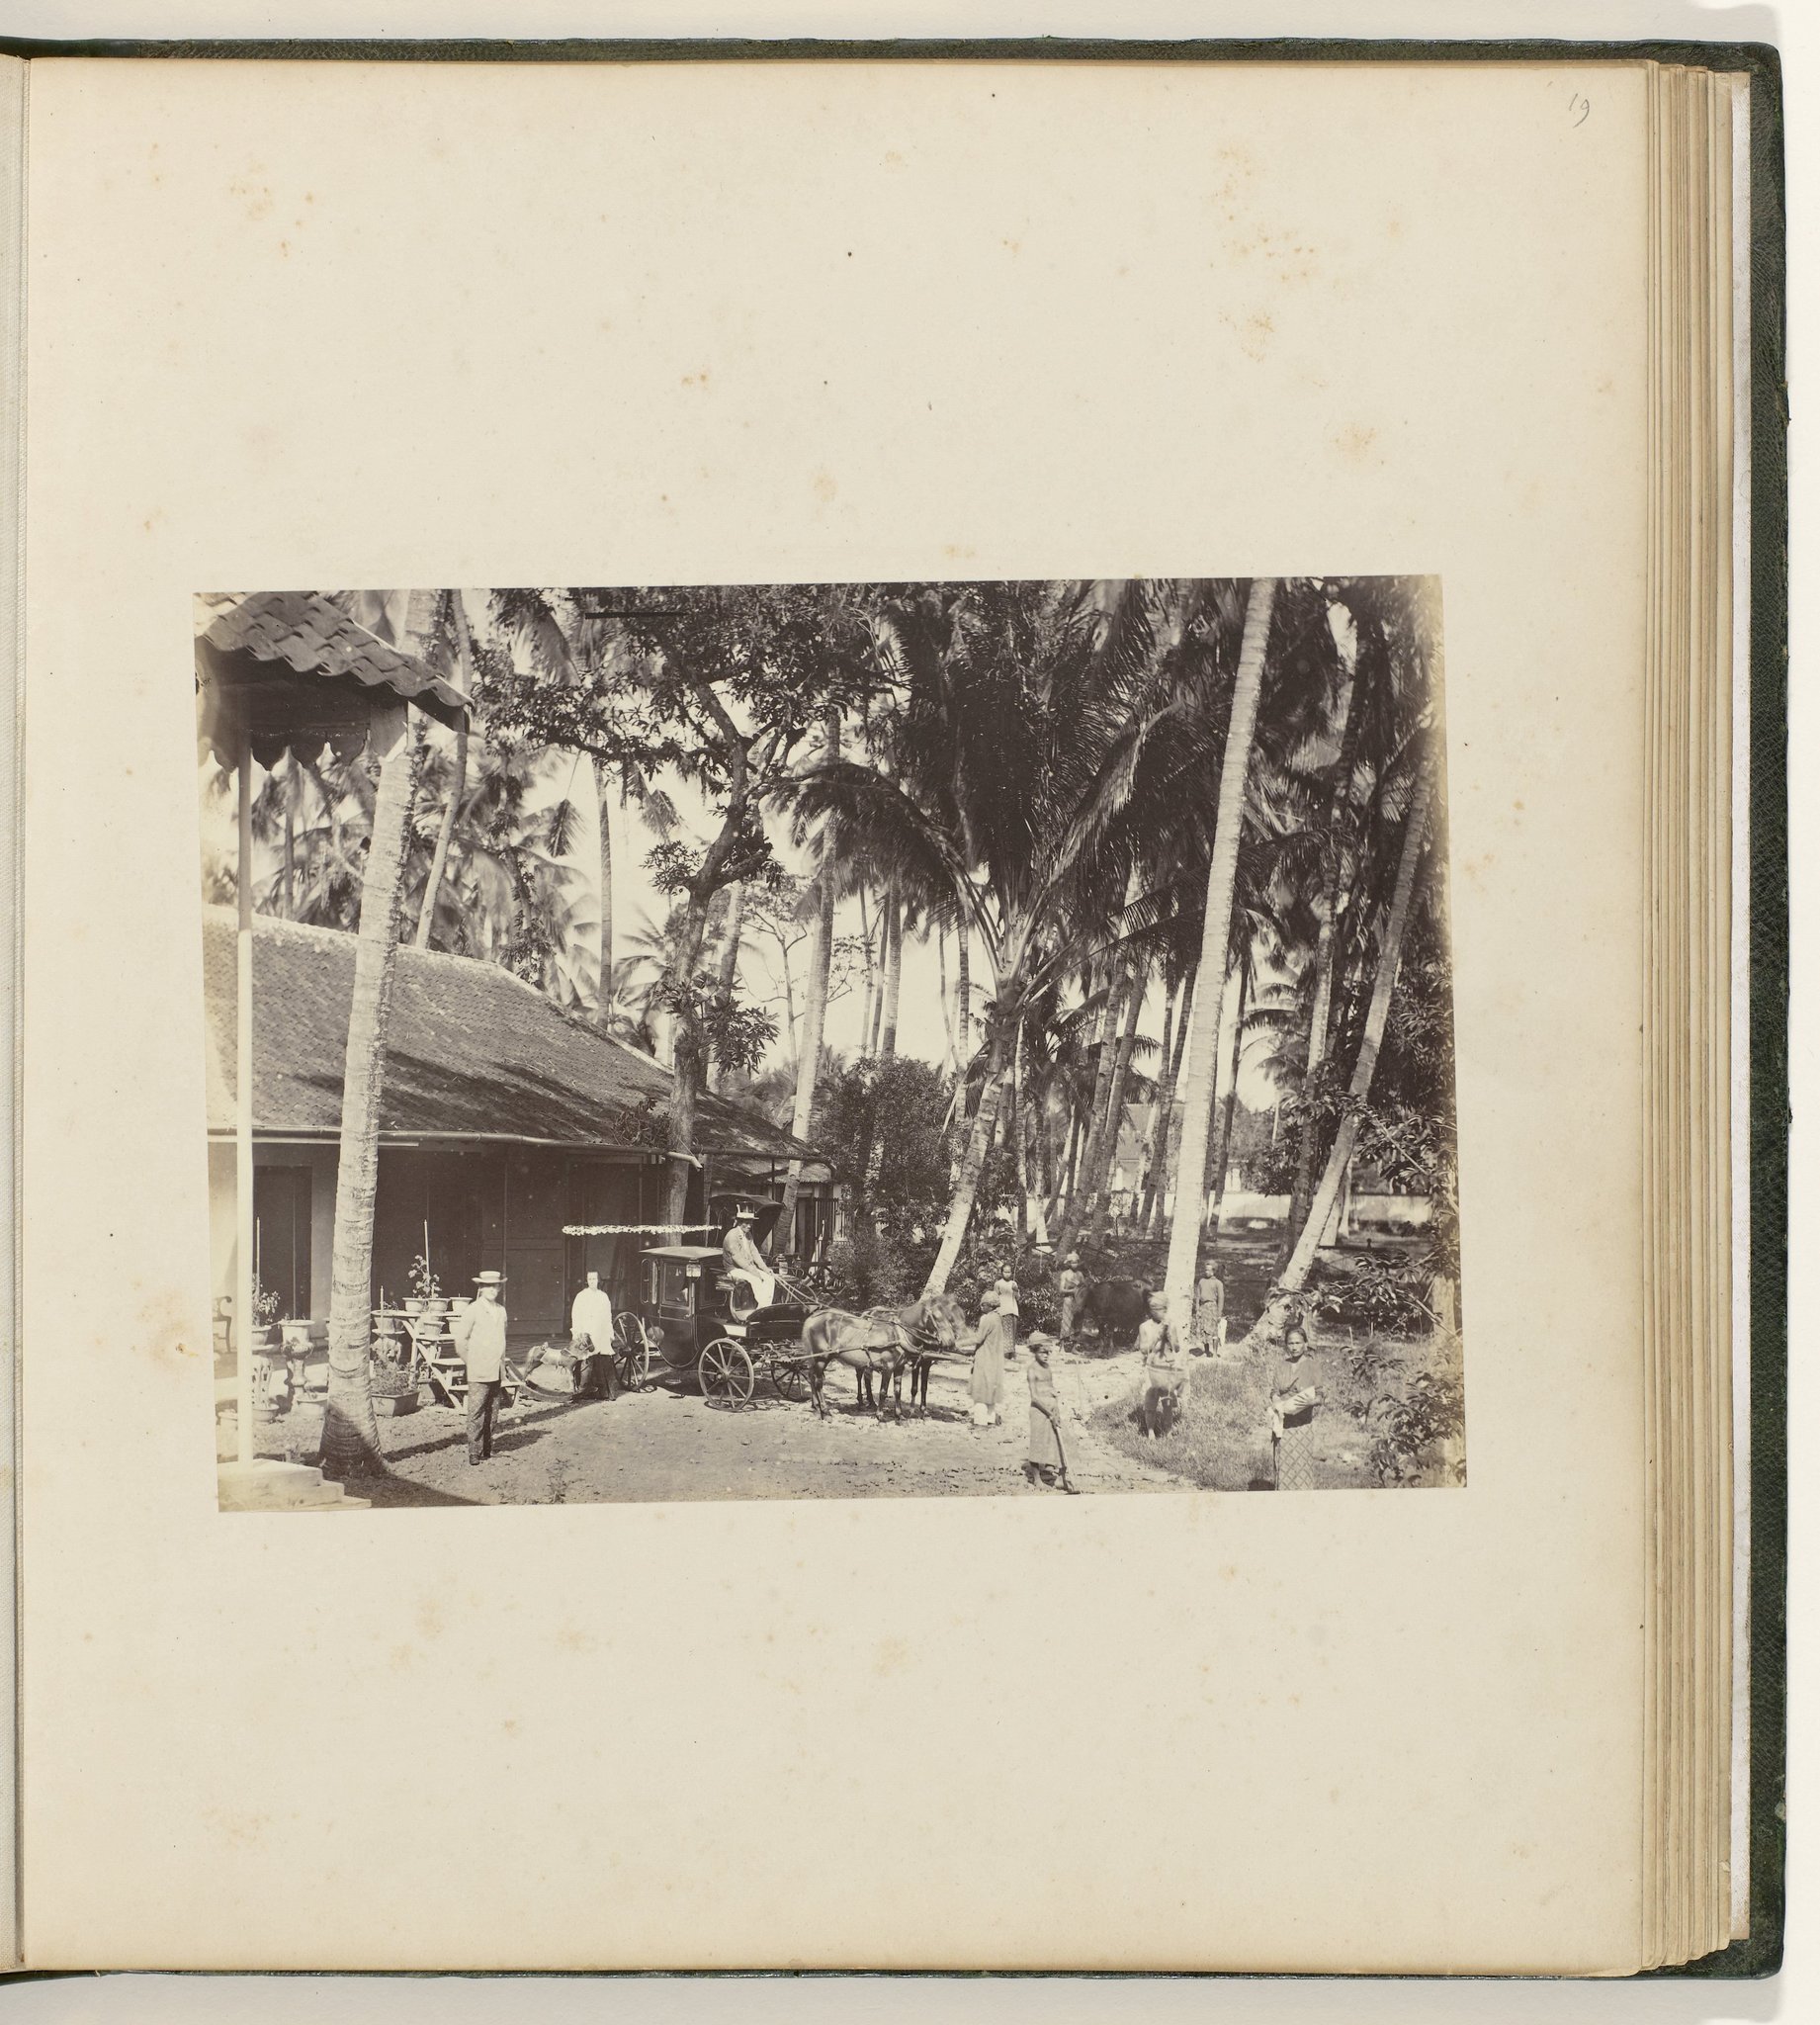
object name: photograph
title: Huis onder palmen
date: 1863-1866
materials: photographic support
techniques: albumen print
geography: batavia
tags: detached house in city, batavia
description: Gezicht op een woonhuis onder palmen. Voor het huis een Europees paar bij een hobbelpaard, voor het huis een rijtuig met koetsier en twee paarden en Indisch personeel, waarschijnlijk te Batavia. Onderdeel van het tweede groene fotoalbum met foto's van Java, uit het bezit van apotheker Specht-Grijp, die in 1865 vanuit Batavia naar Nederland terugkeerde.